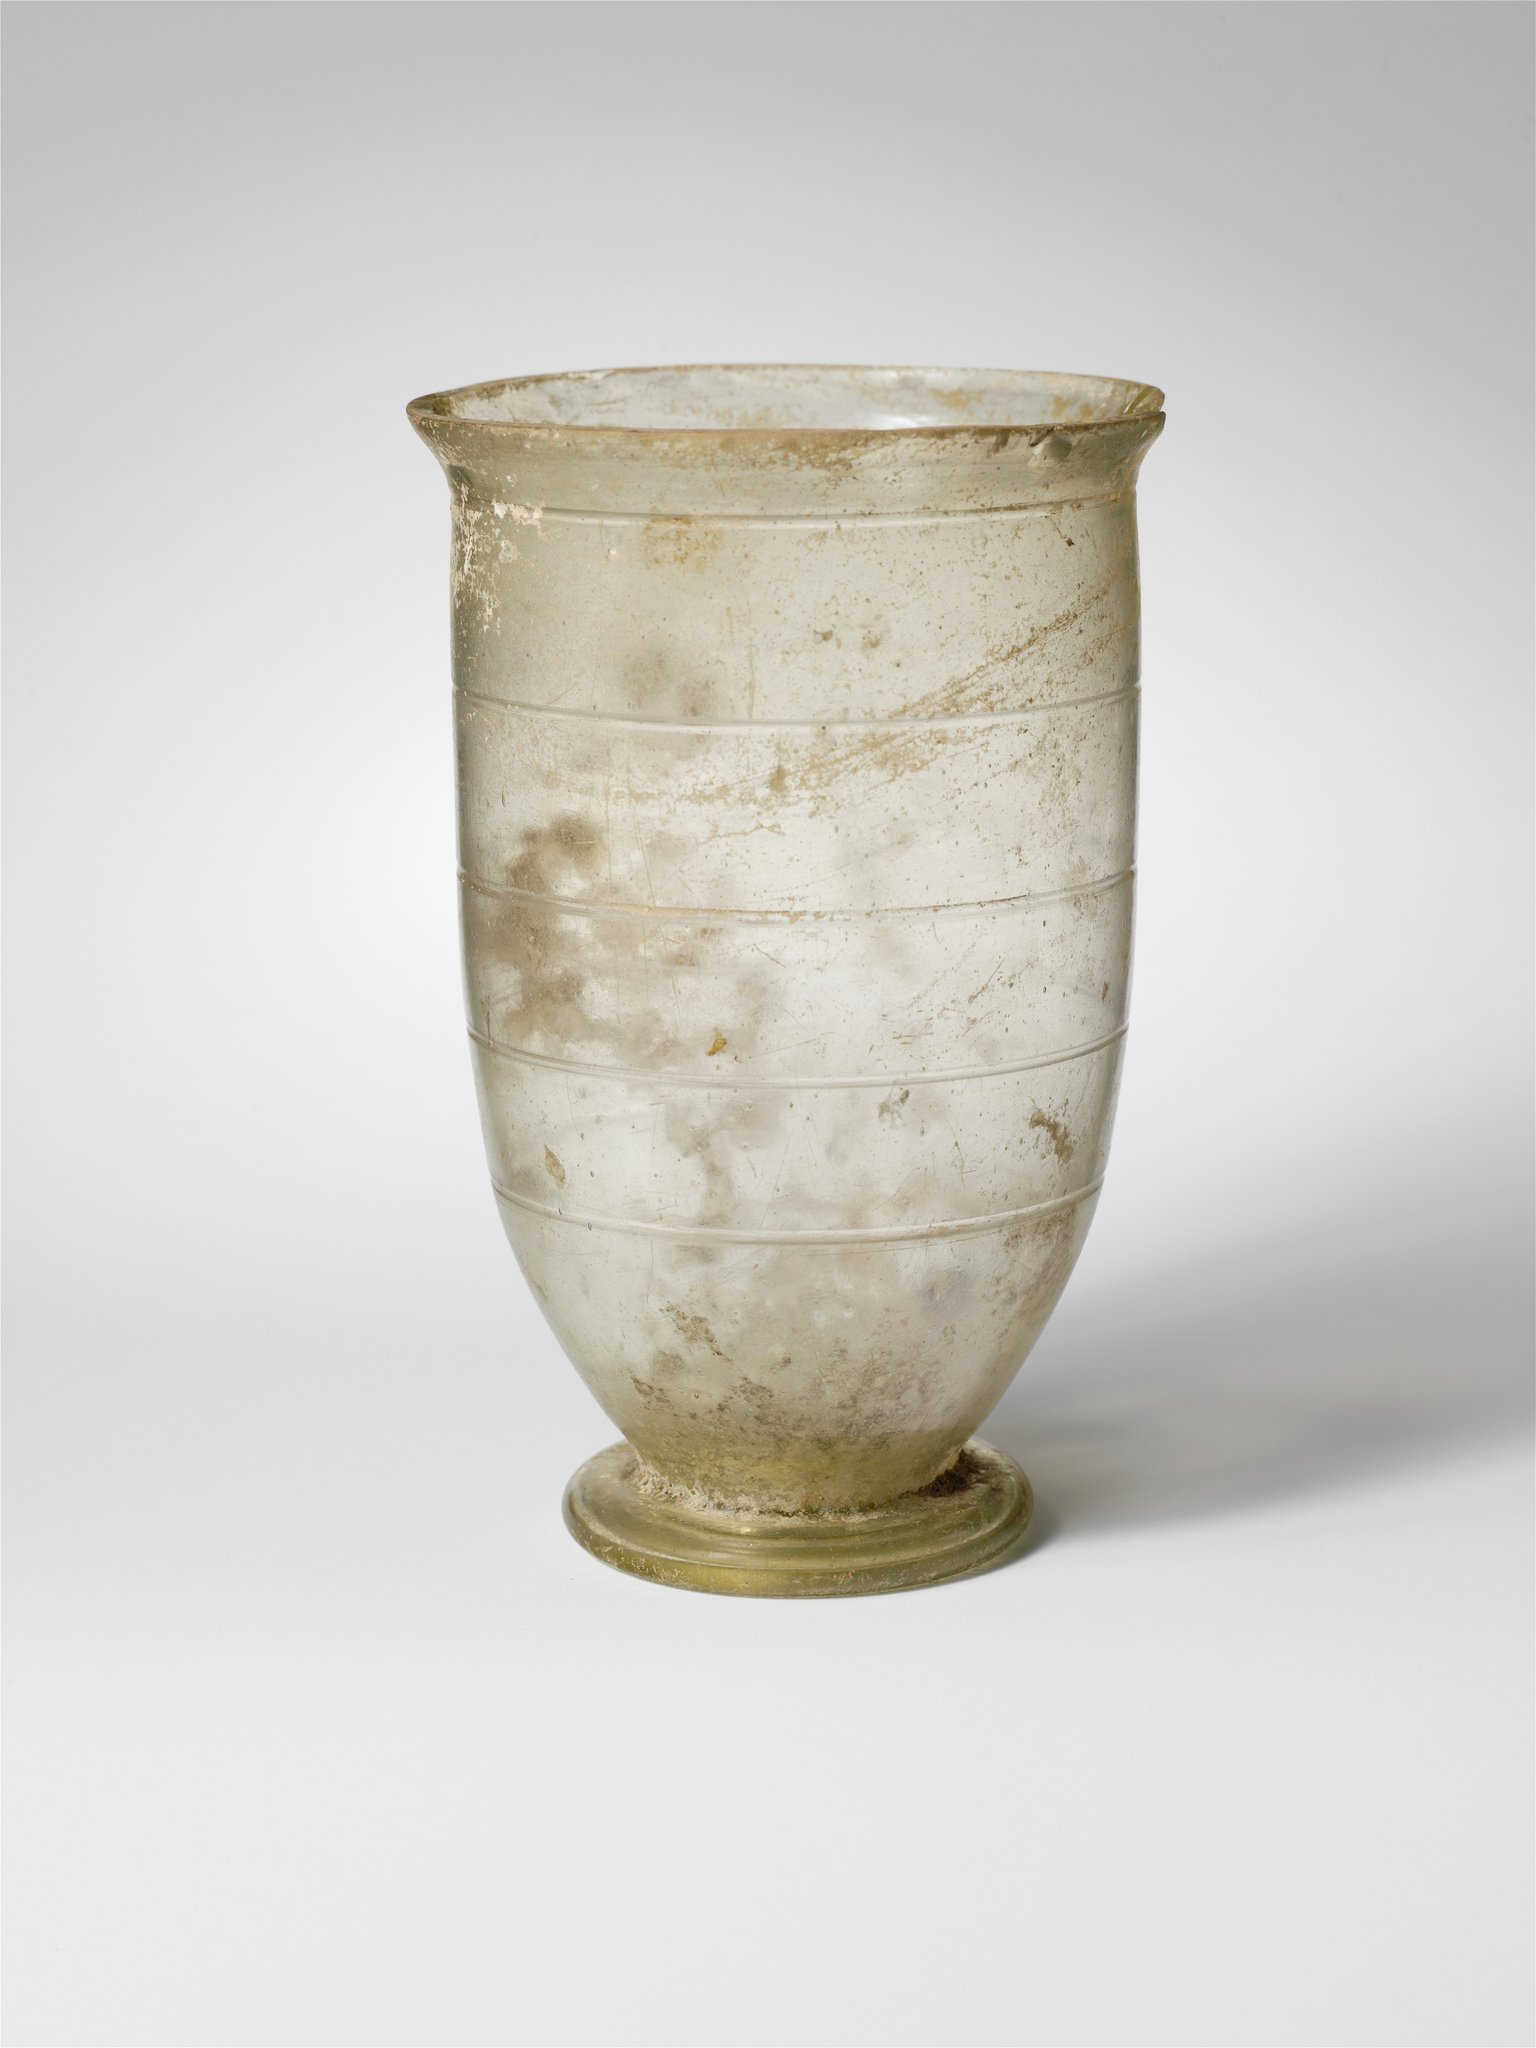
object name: beaker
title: Glass beaker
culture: roman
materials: glass